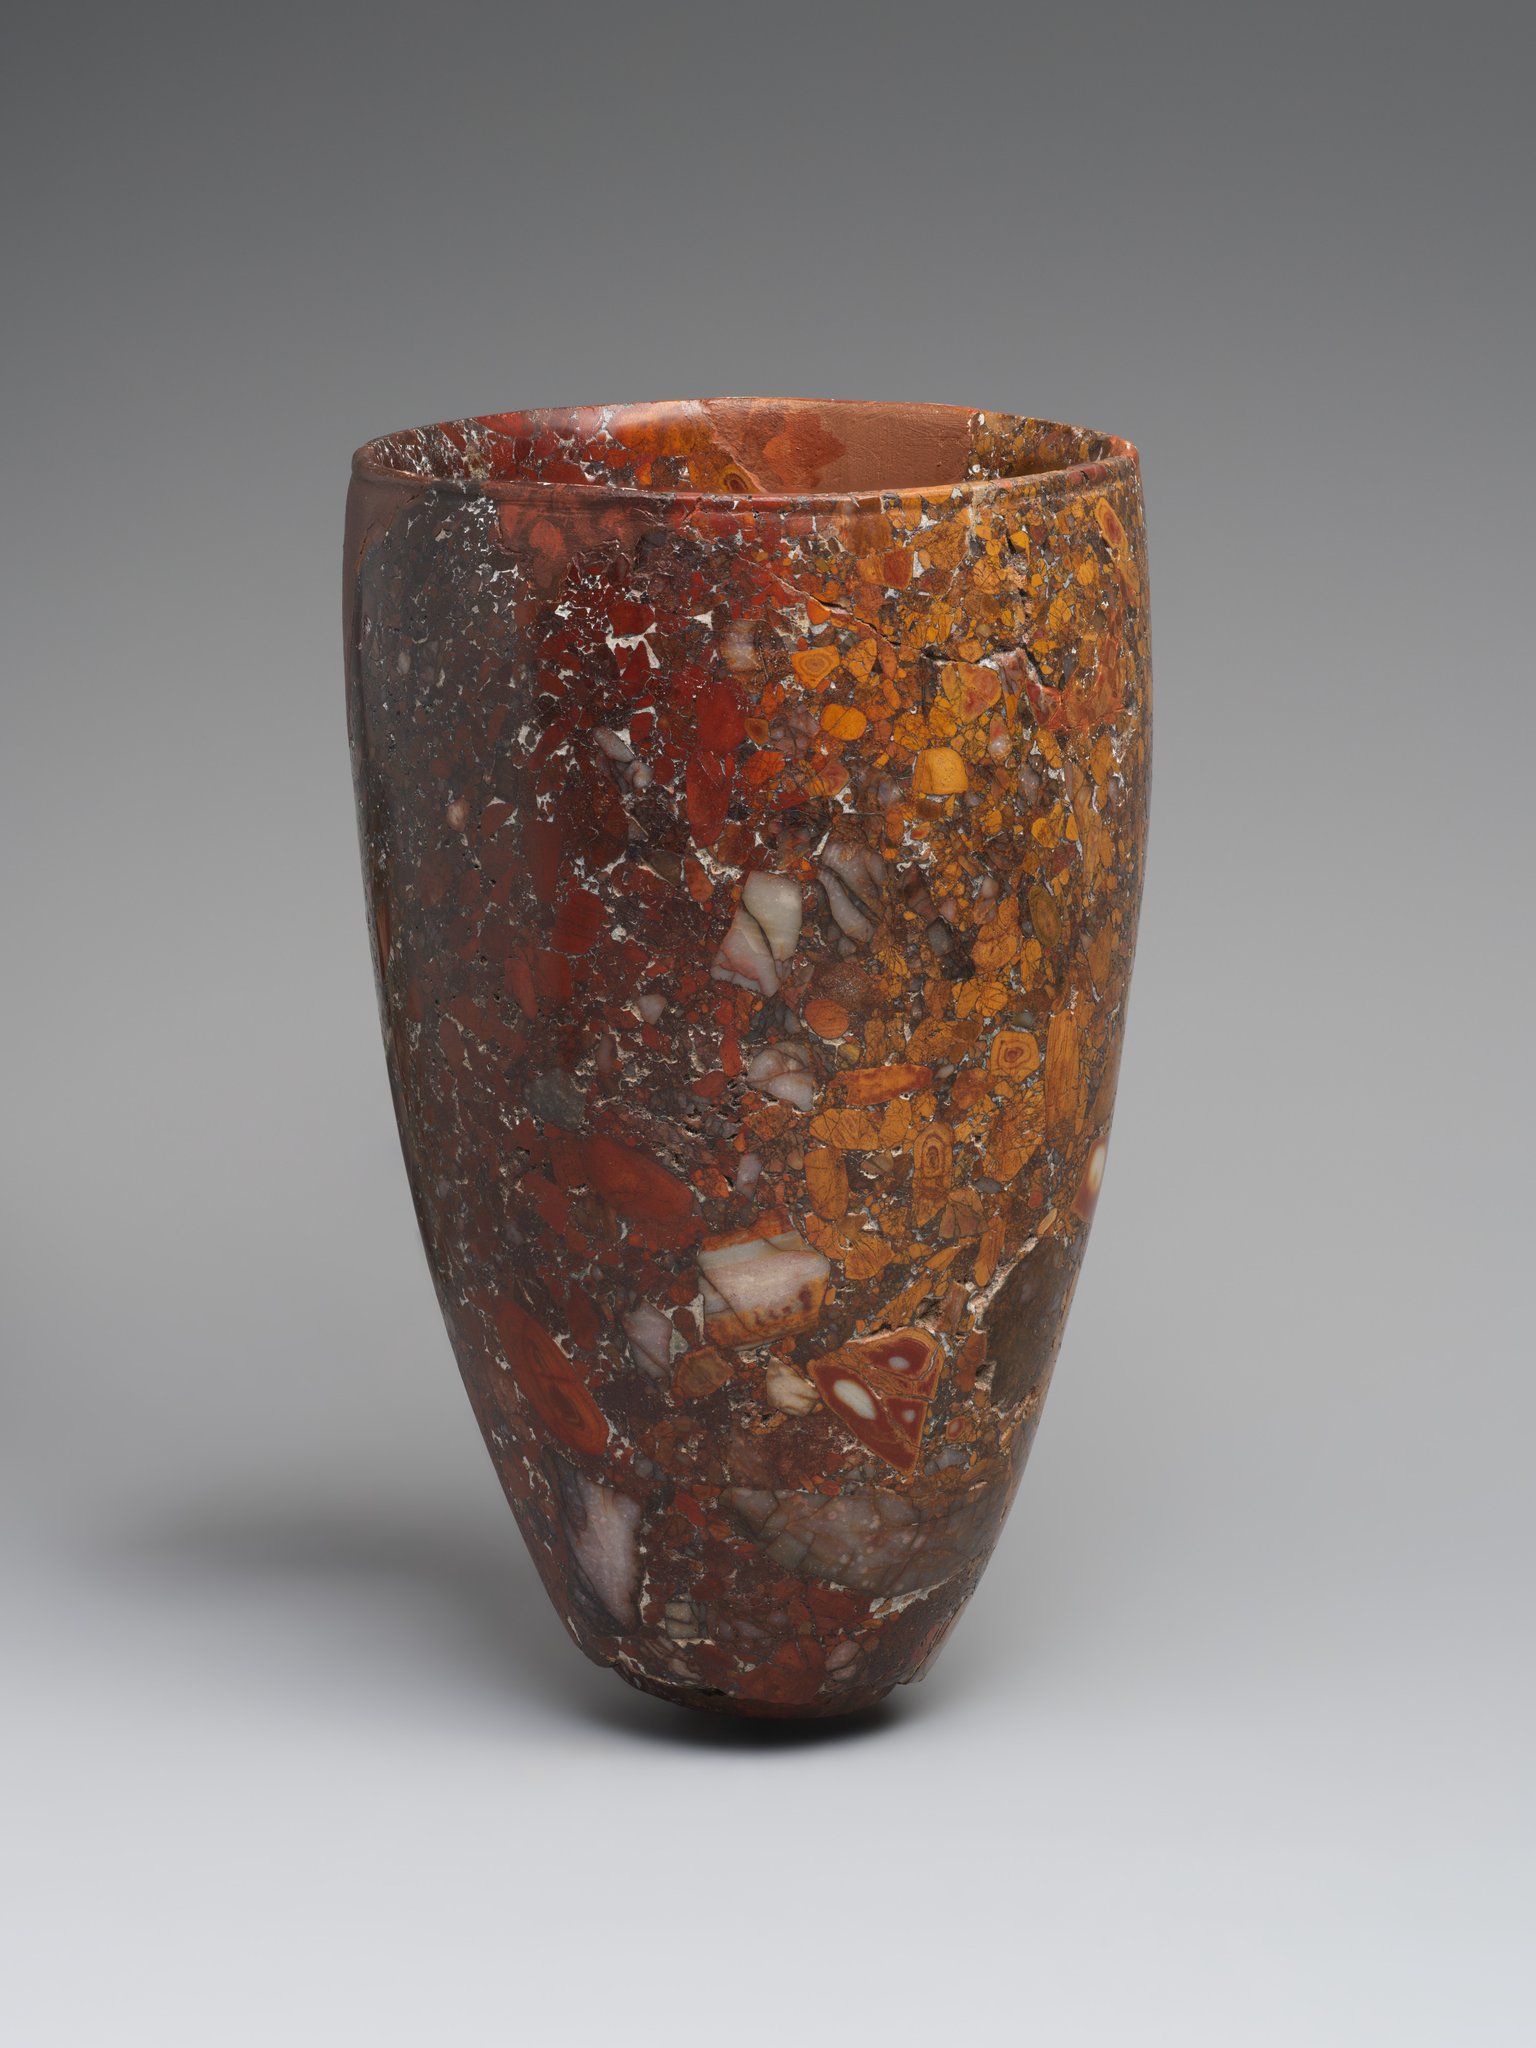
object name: beaker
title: Beaker with bronze pin in base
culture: iranian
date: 900-801 BCE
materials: bronze, jasper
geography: iran